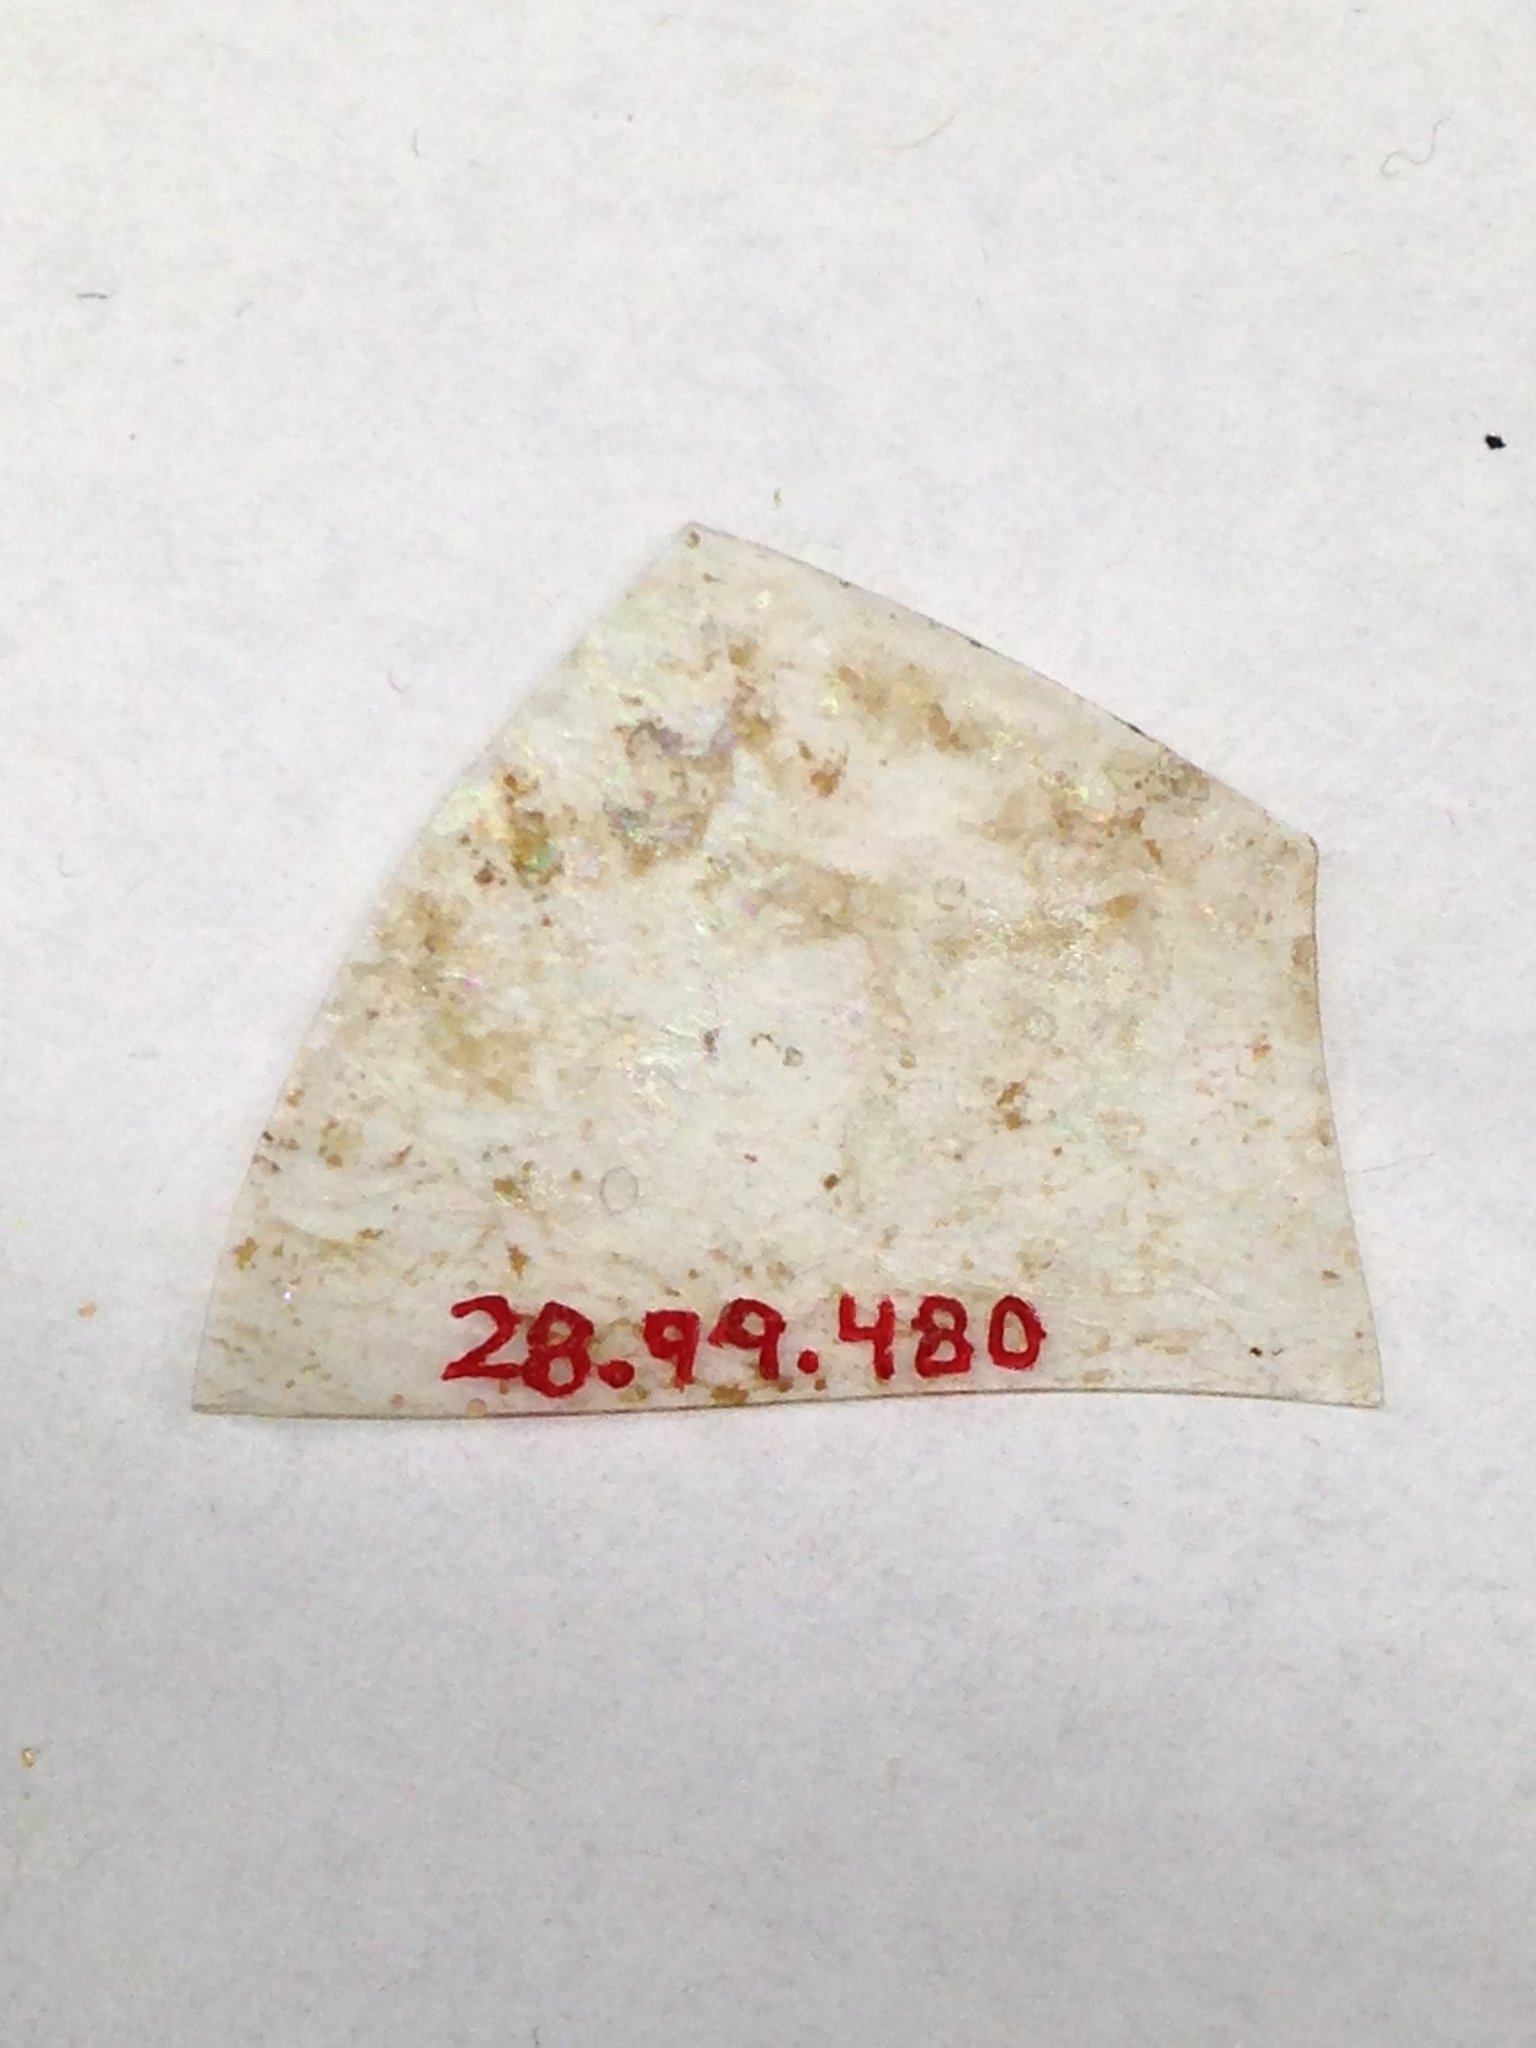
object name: fragment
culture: european or middle eastern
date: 1150-1250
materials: ceramic, glass